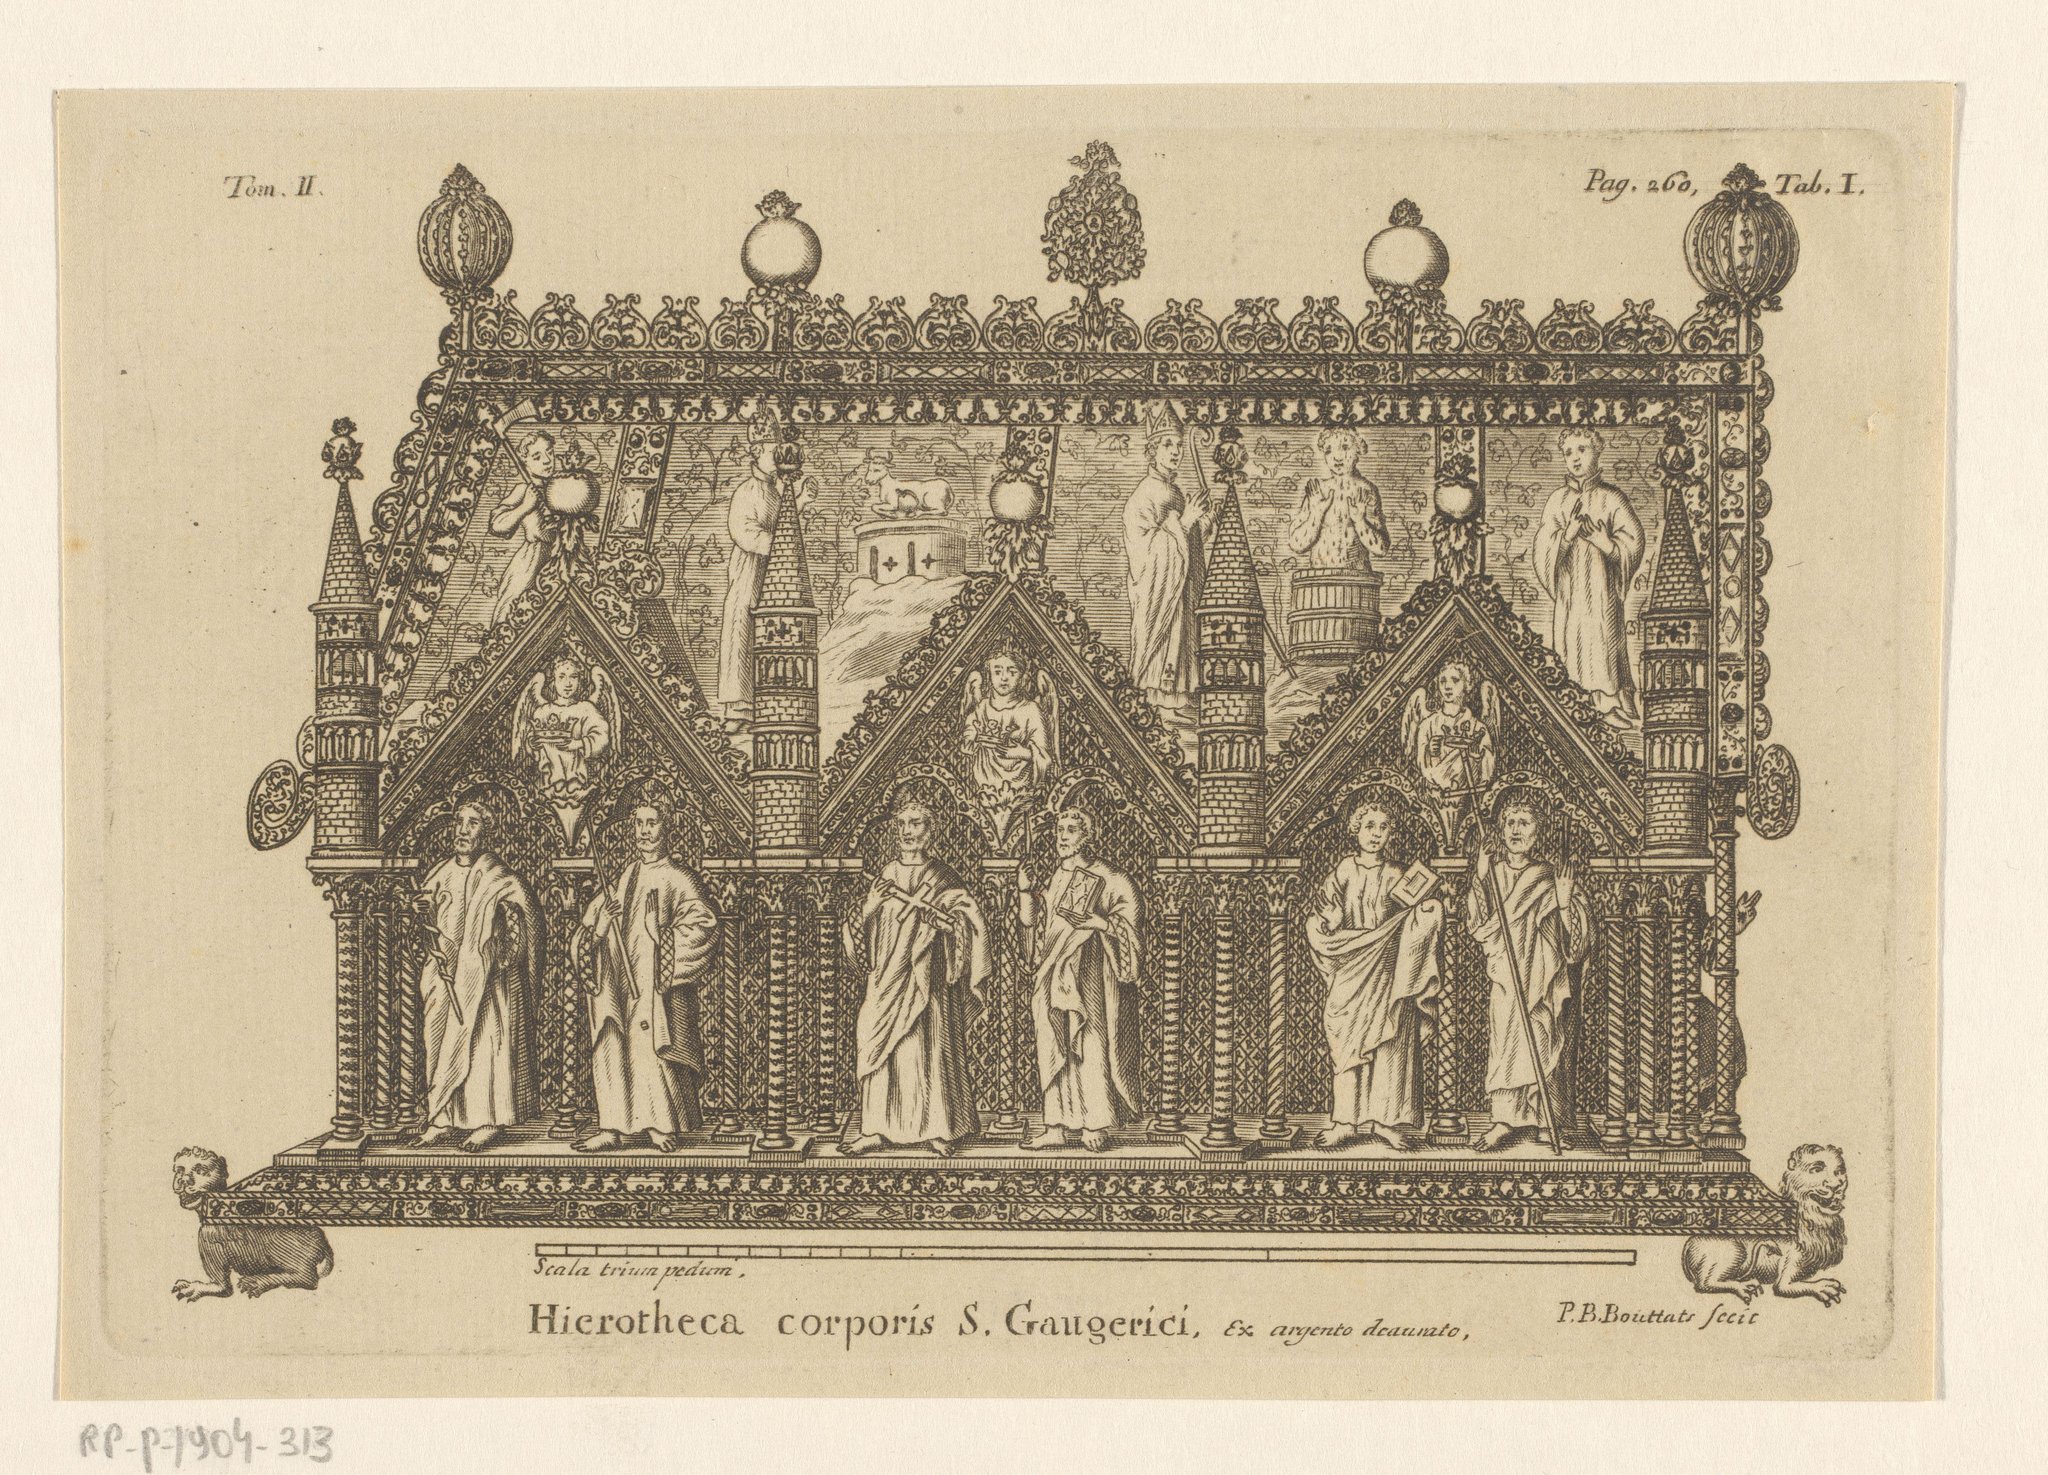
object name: titelblad, titelpagina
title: Reliekschrijn van de Heilige Gorik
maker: pieter balthasar bouttats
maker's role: print maker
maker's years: 1666-1755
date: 1676-1755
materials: paper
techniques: engraving, etching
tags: saints, relics (and reliquaries), ornamenting, decorating ~ applied arts, scales of notation (arithmetic), male saints (gaugericus), the apostle peter, first bishop of rome; possible attributes: book, cock, (upturned) cross, (triple) crozier, fish, key, scroll, ship, tiara, the apostle paul of tarsus; possible attributes: book, scroll, sword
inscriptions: collector's mark: Lugt 2228, inscription: ‘Pag. 260, Tab. I.’, inscription: ‘Tom II’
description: Een afbeelding uit een boek. Een reliekschrijn, frontaal. Het schrijn wordt gedragen door liggende leeuwen. Het schrijn zelf is versierd met architectonische krullen. Drie portalen aan de voorkant bevatten telkens twee heiligen, o.a. Petrus en Paulus. Het dak van het schrijn is versierd met afbeeldingen van andere heiligen. Een schaal onder het schrijn toont de verhoudingen.